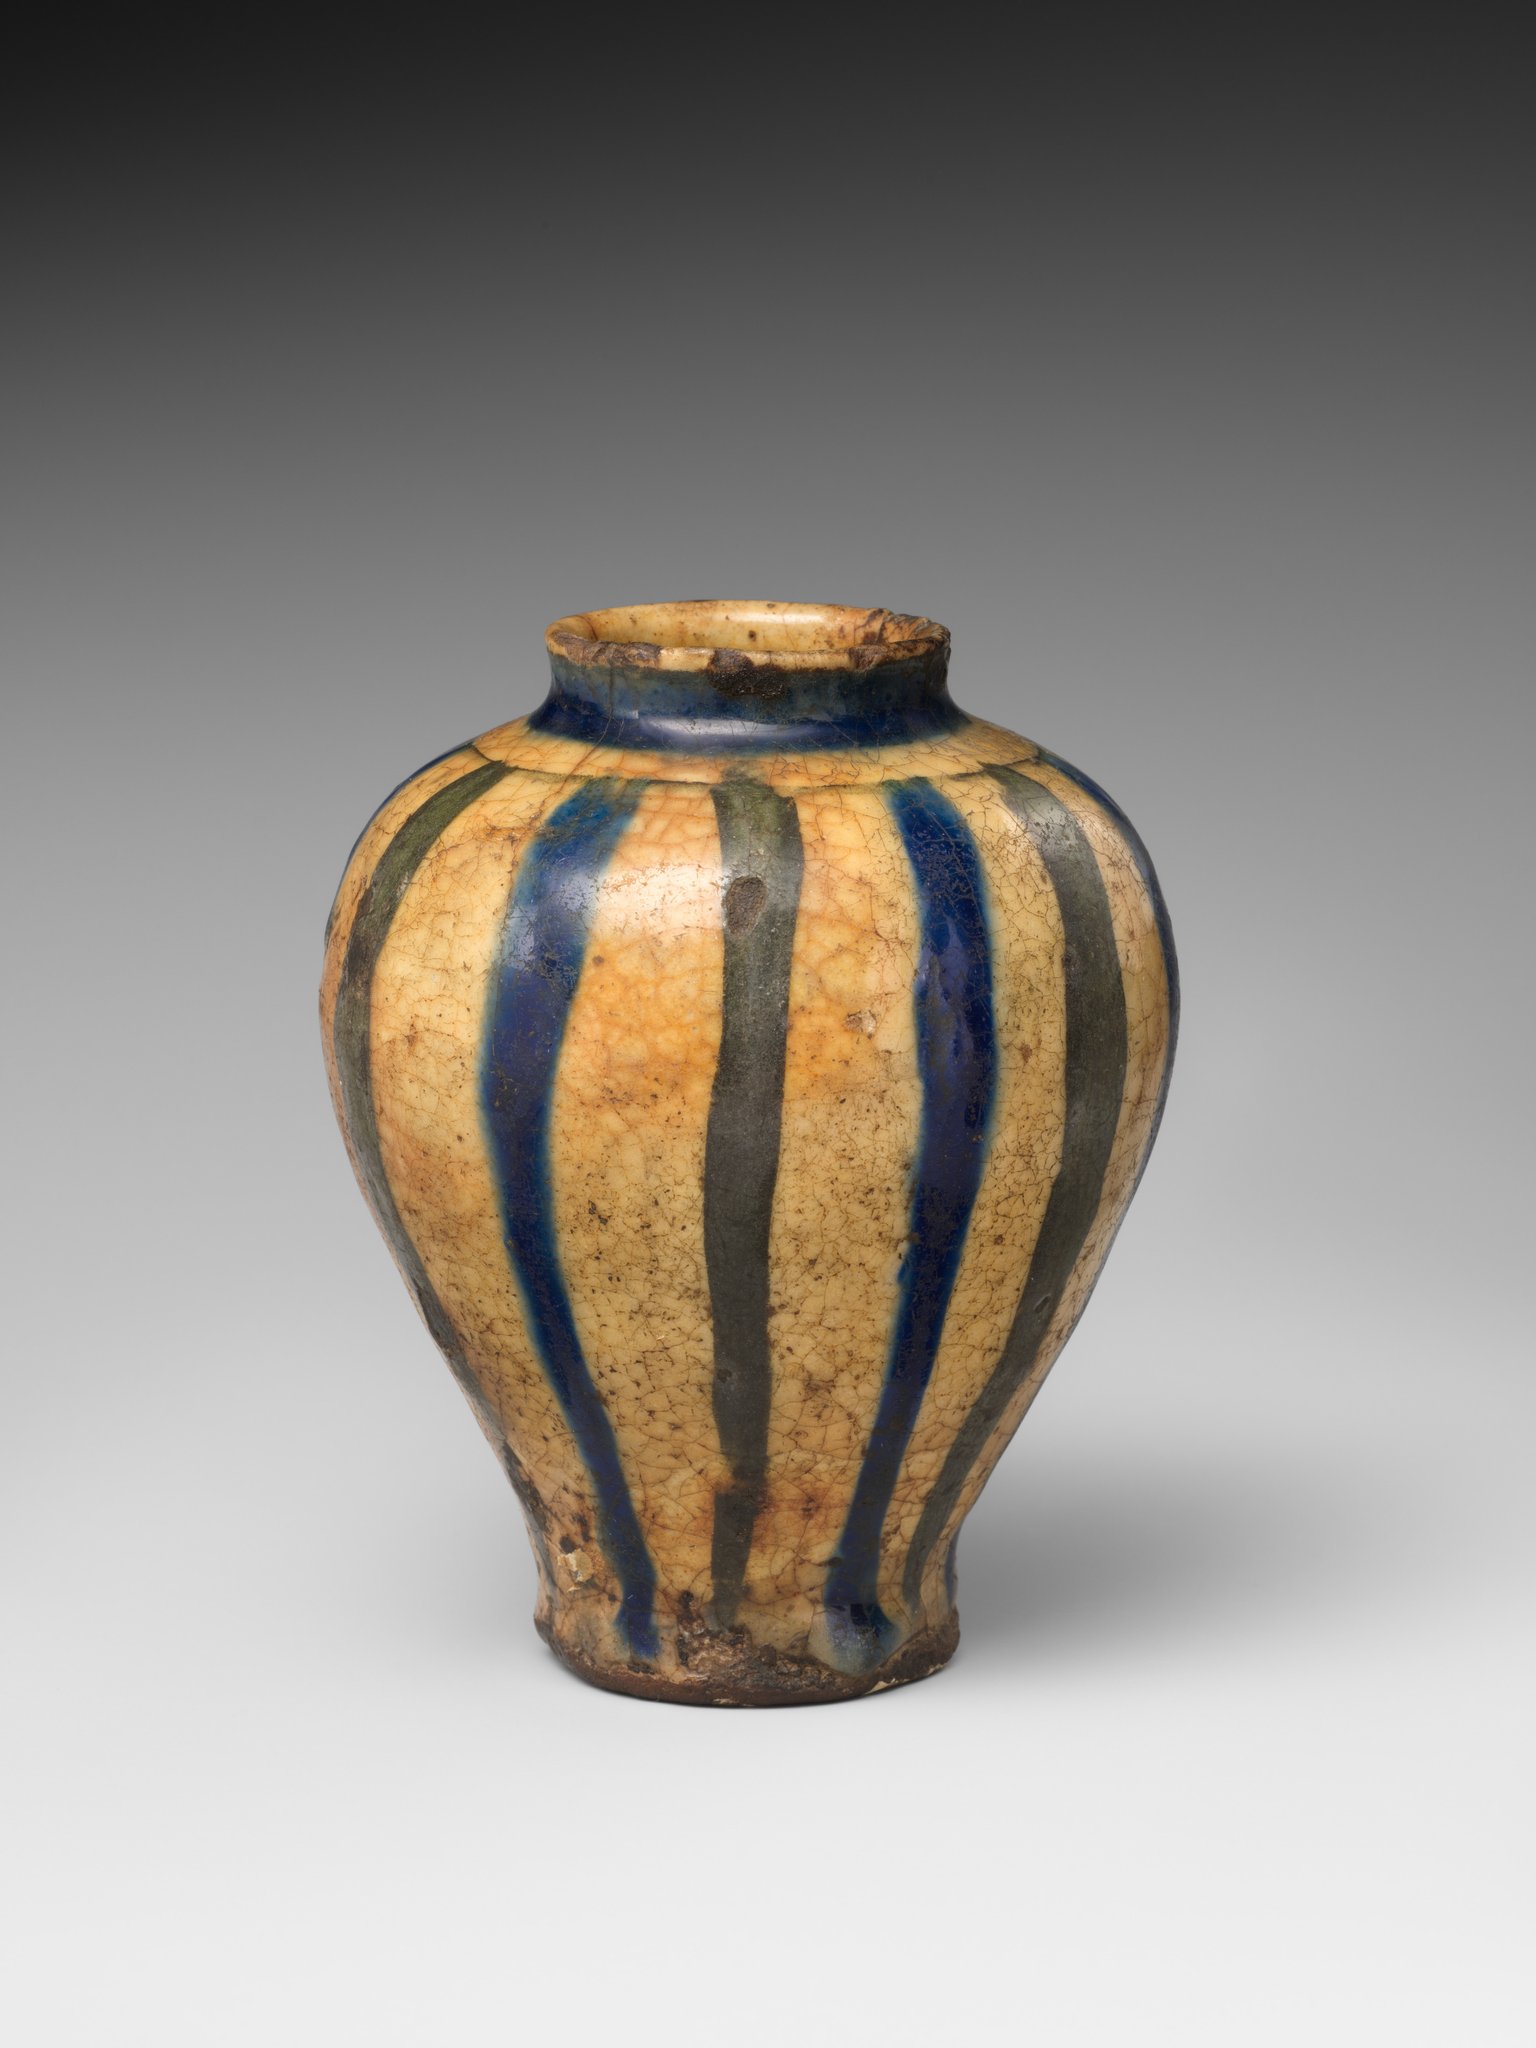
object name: vase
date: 1701-1800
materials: stonepaste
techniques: glazing, painting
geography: iran